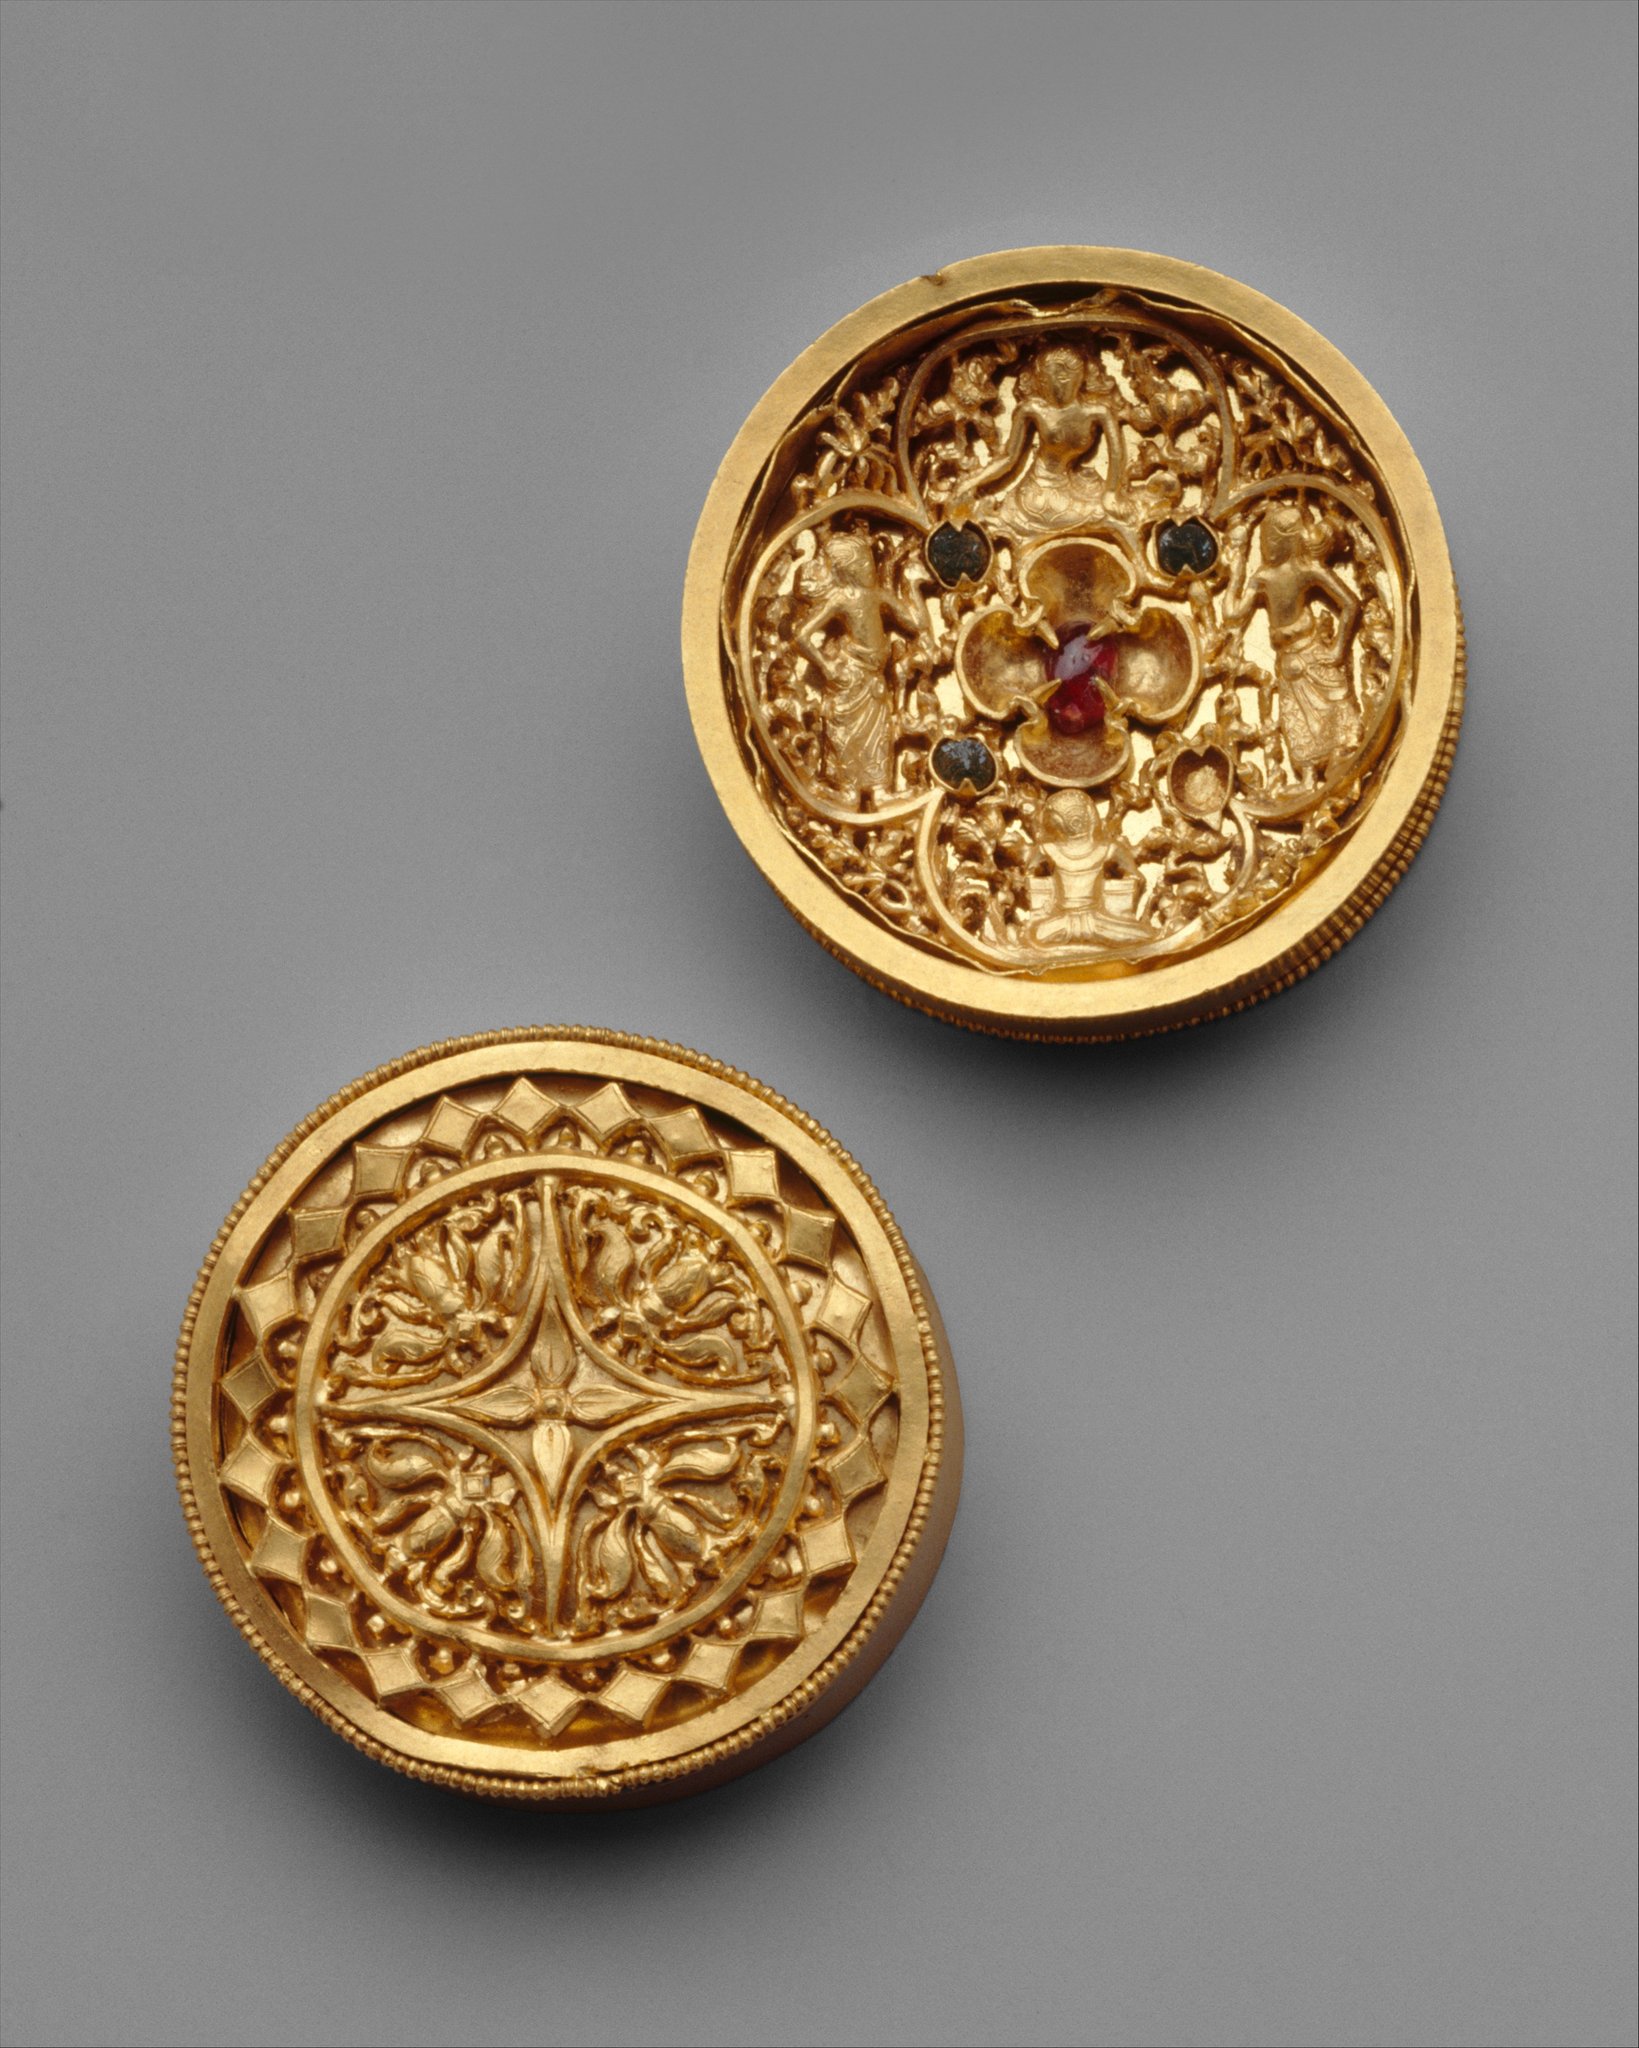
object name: earplug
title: Pair of Earplugs Ornamented with Figures and Inlaid Stones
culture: indonesian, javanese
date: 801-1400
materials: gold